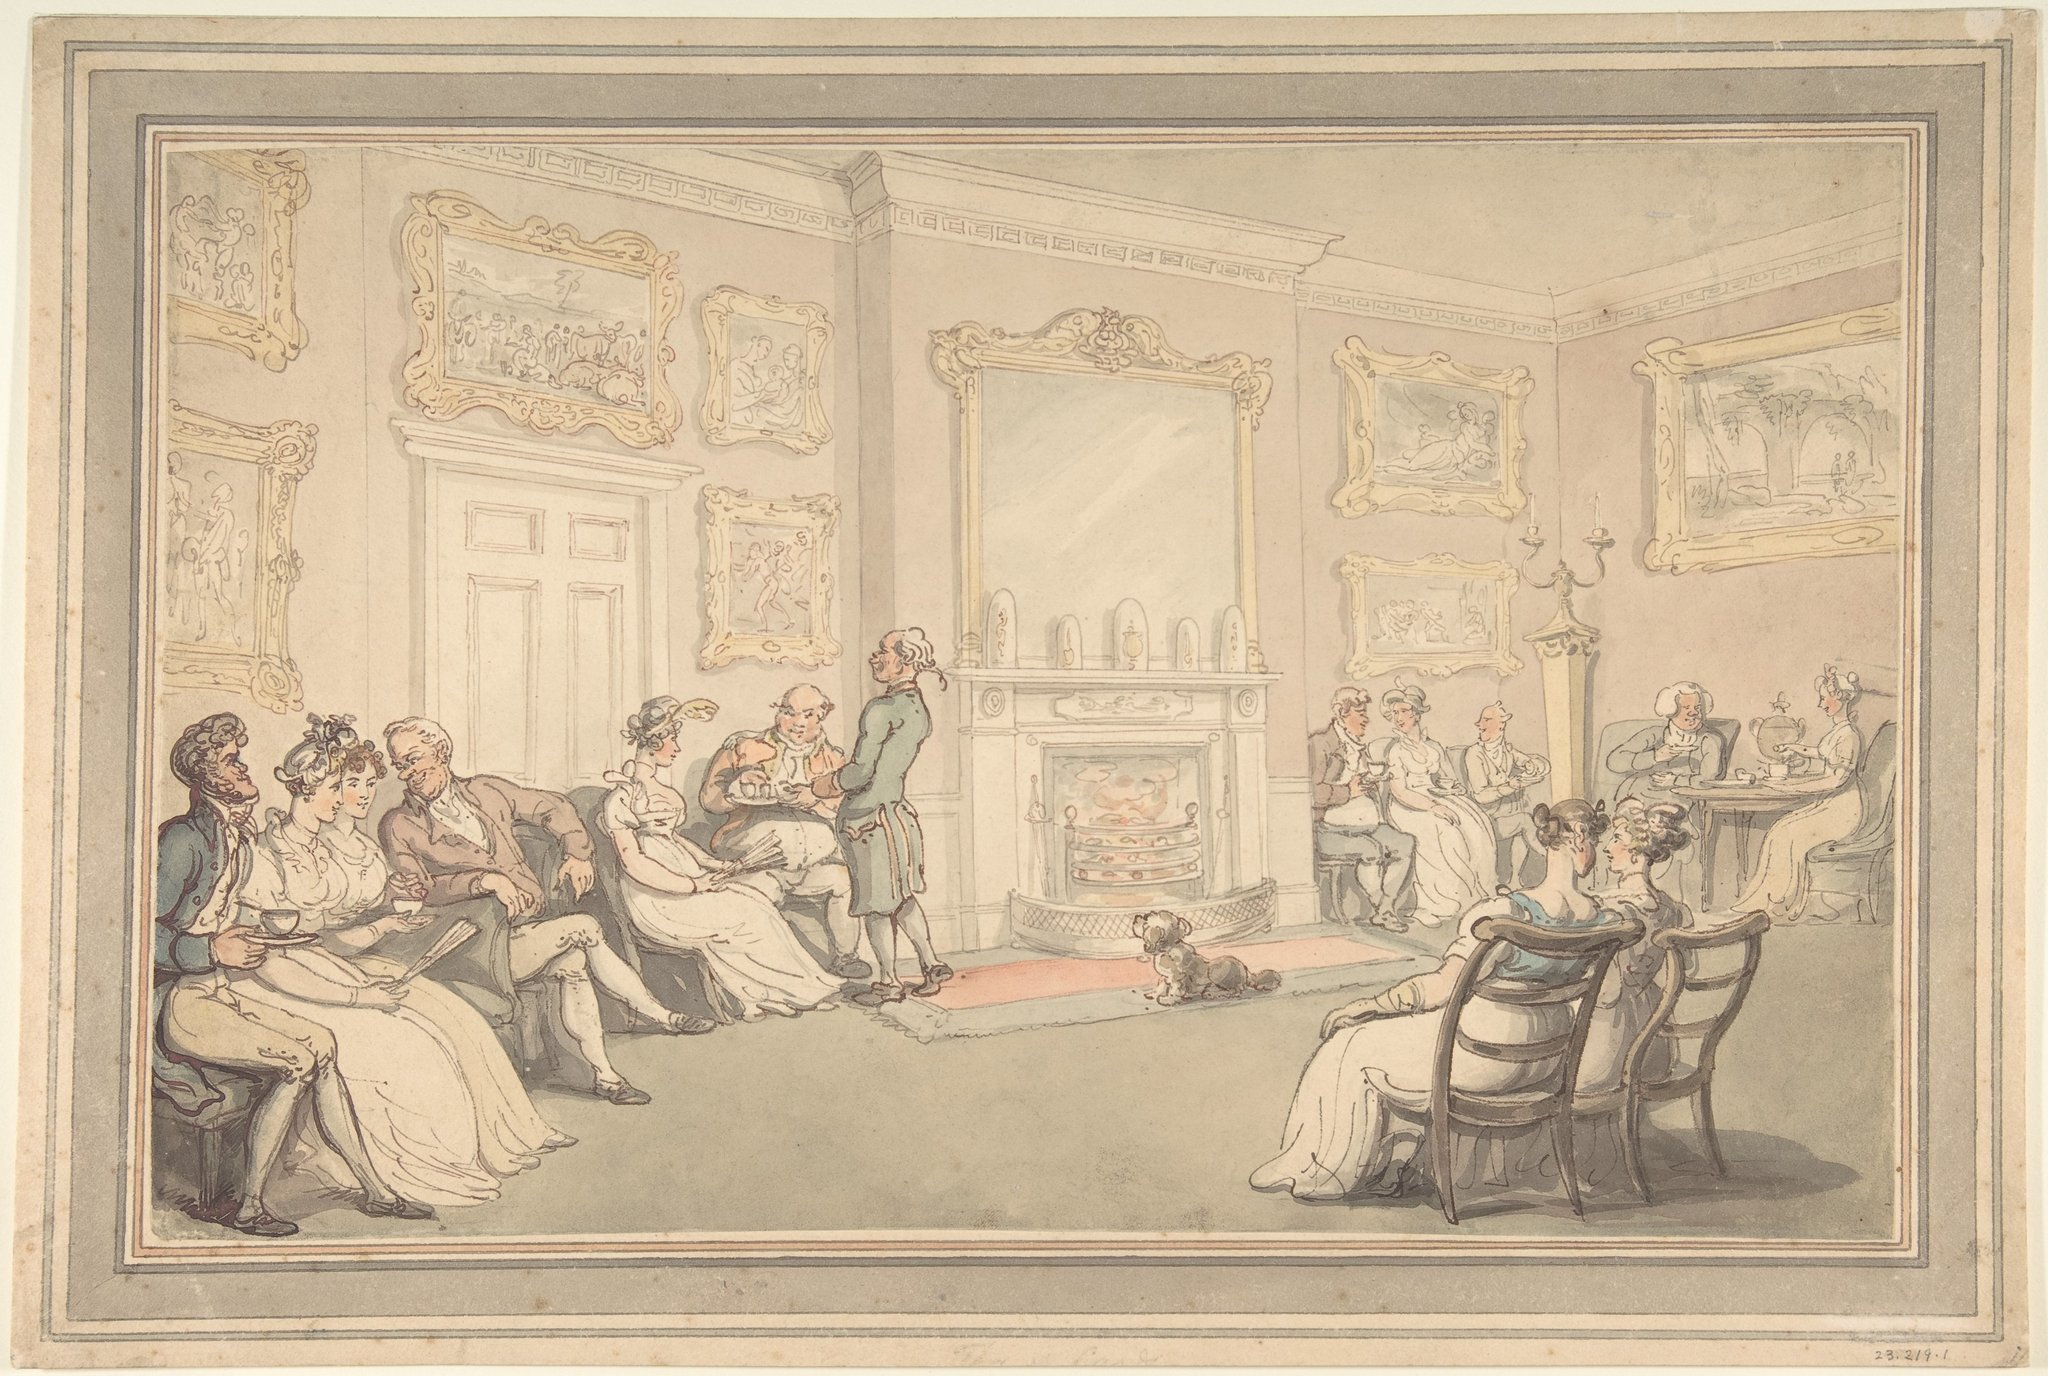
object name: drawing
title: The Reception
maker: thomas rowlandson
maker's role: artist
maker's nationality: british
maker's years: 1757-1827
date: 1780-1827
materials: ink, watercolor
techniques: brush, pen, wash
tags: animals,men,women,party